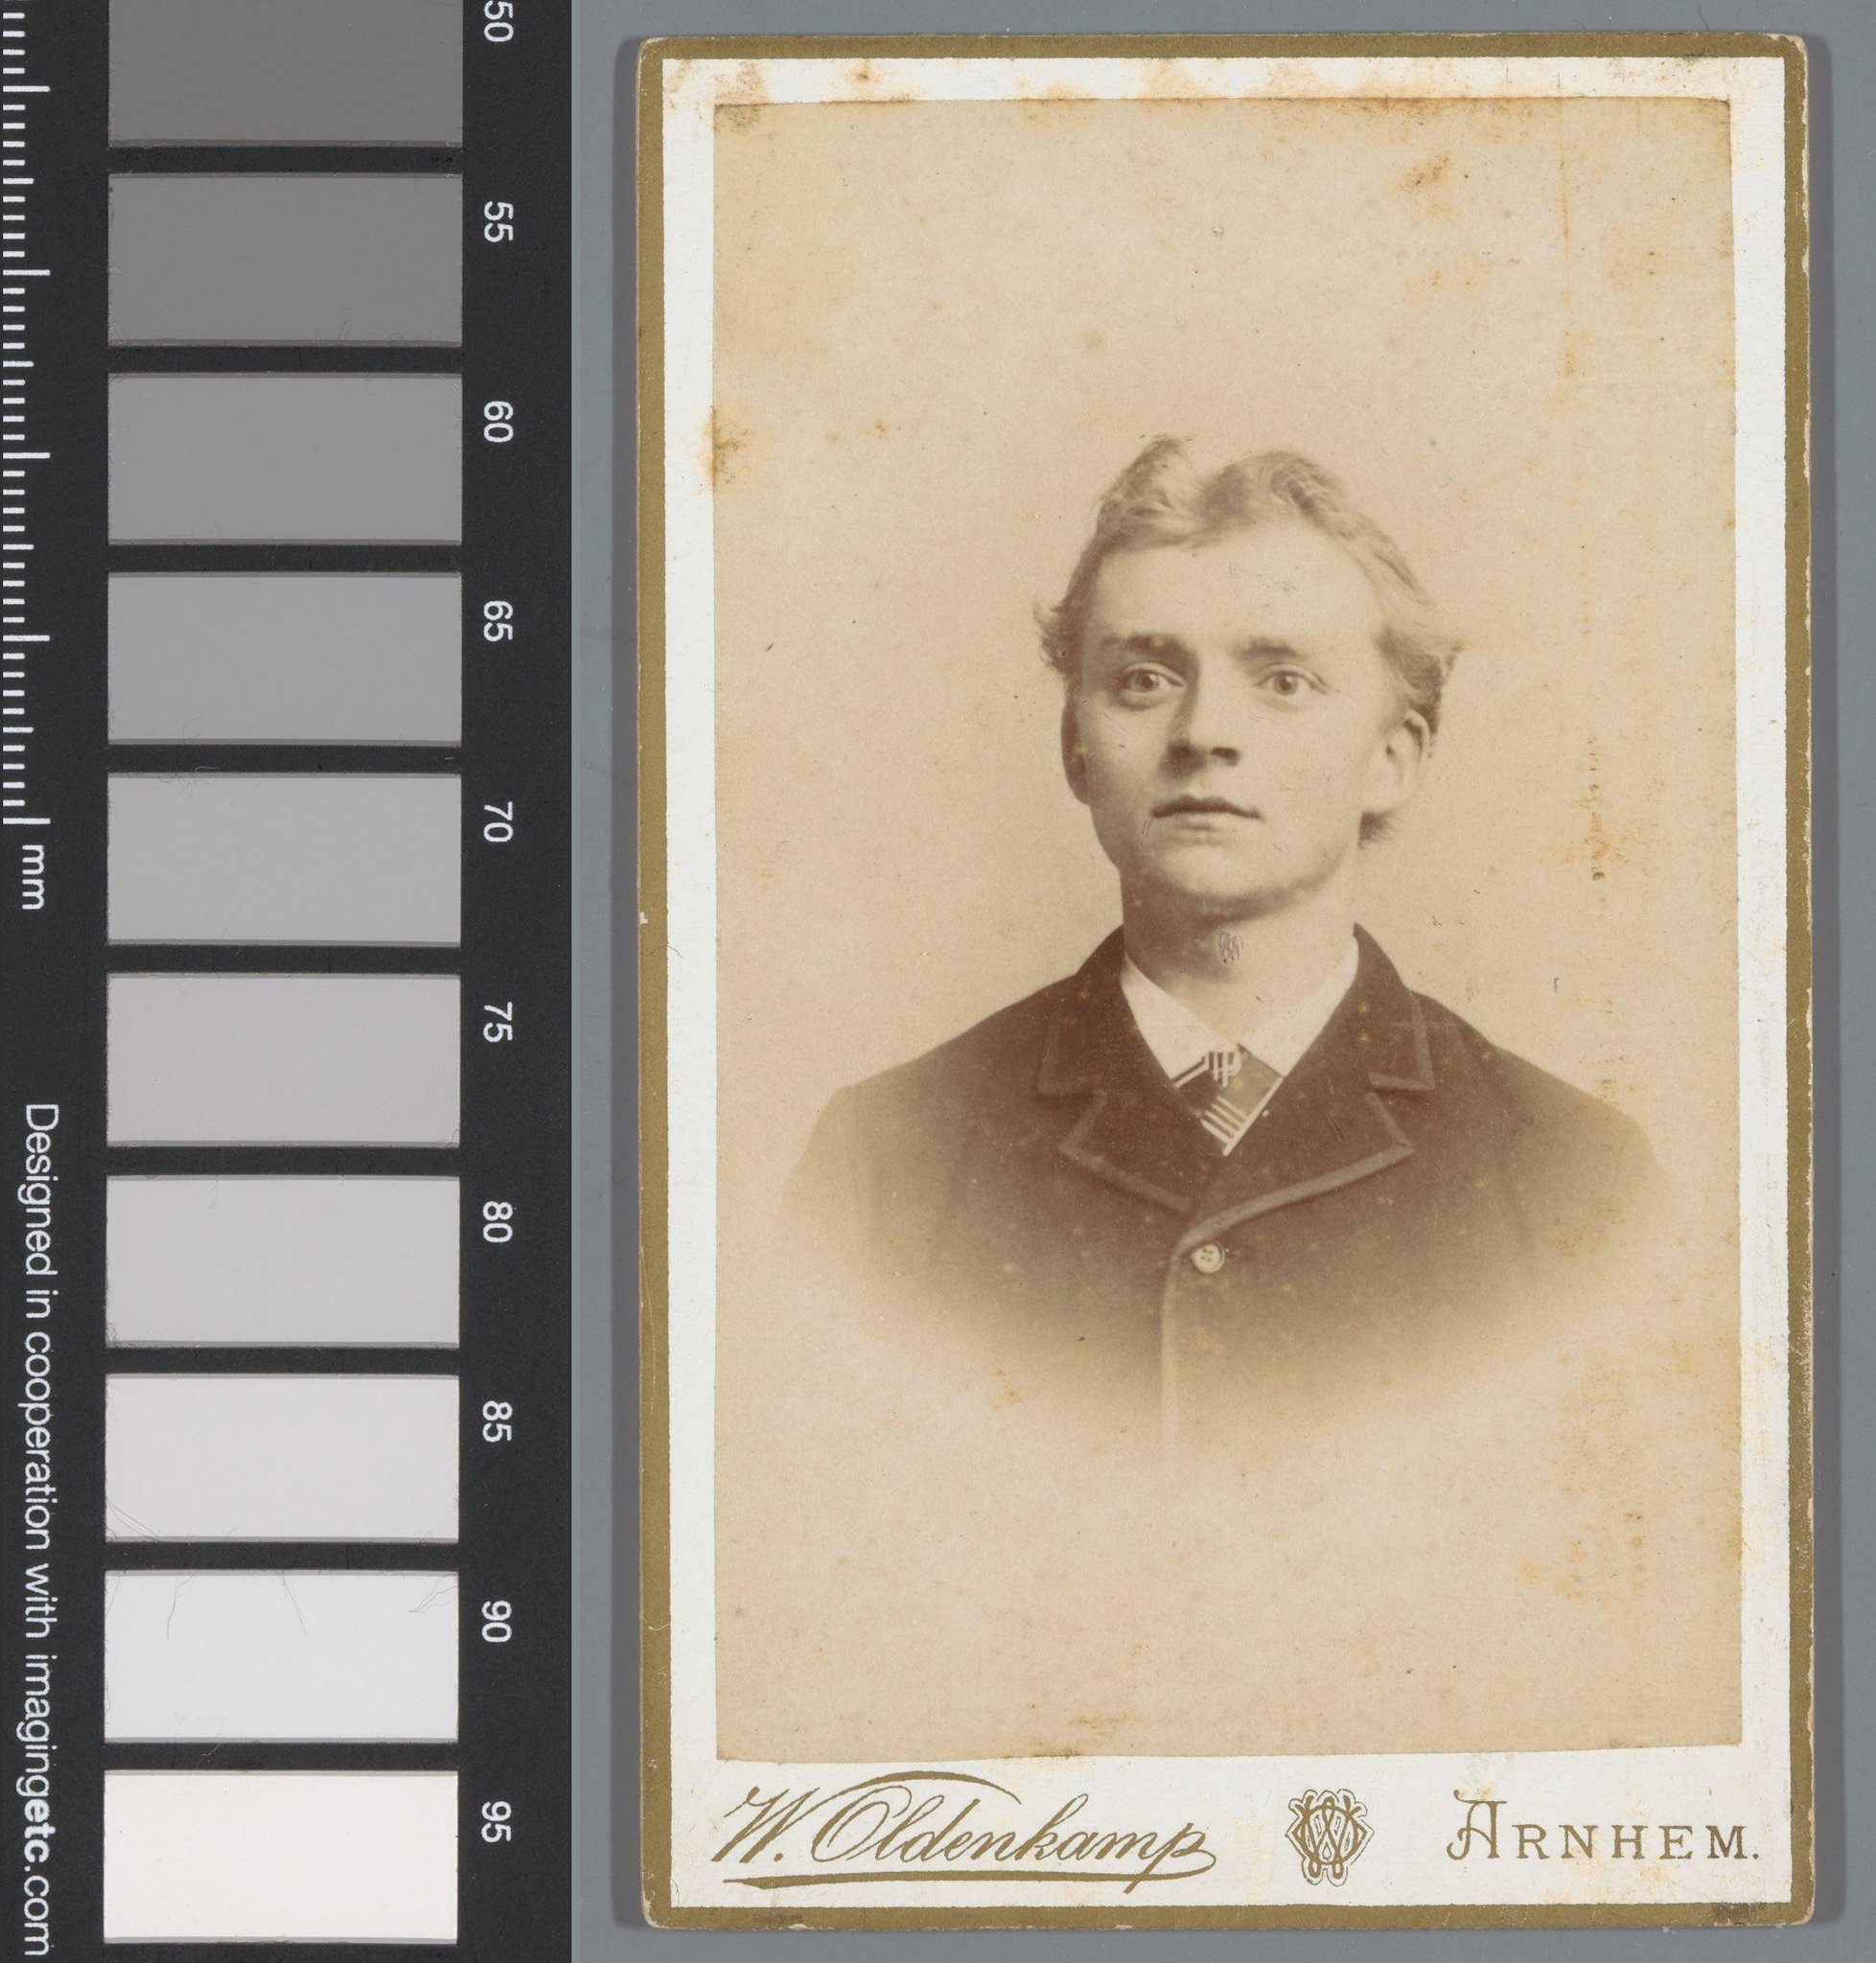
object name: carte de visite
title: Portret van een onbekende man, aangeduid als Berend Mulder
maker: willem oldenkamp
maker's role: fotograaf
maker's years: 1864-1921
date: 1885-1915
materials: cardboard, paper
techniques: albumen print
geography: arnhem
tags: historical persons, youth, adolescent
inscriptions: inscription: ‘Atelier/ W. Oldenkamp/ ARNHEM/ Ridderstraat 27./ Negativen worden voor nabestelling bewaard.’, inscription: ‘Berend Mulder’